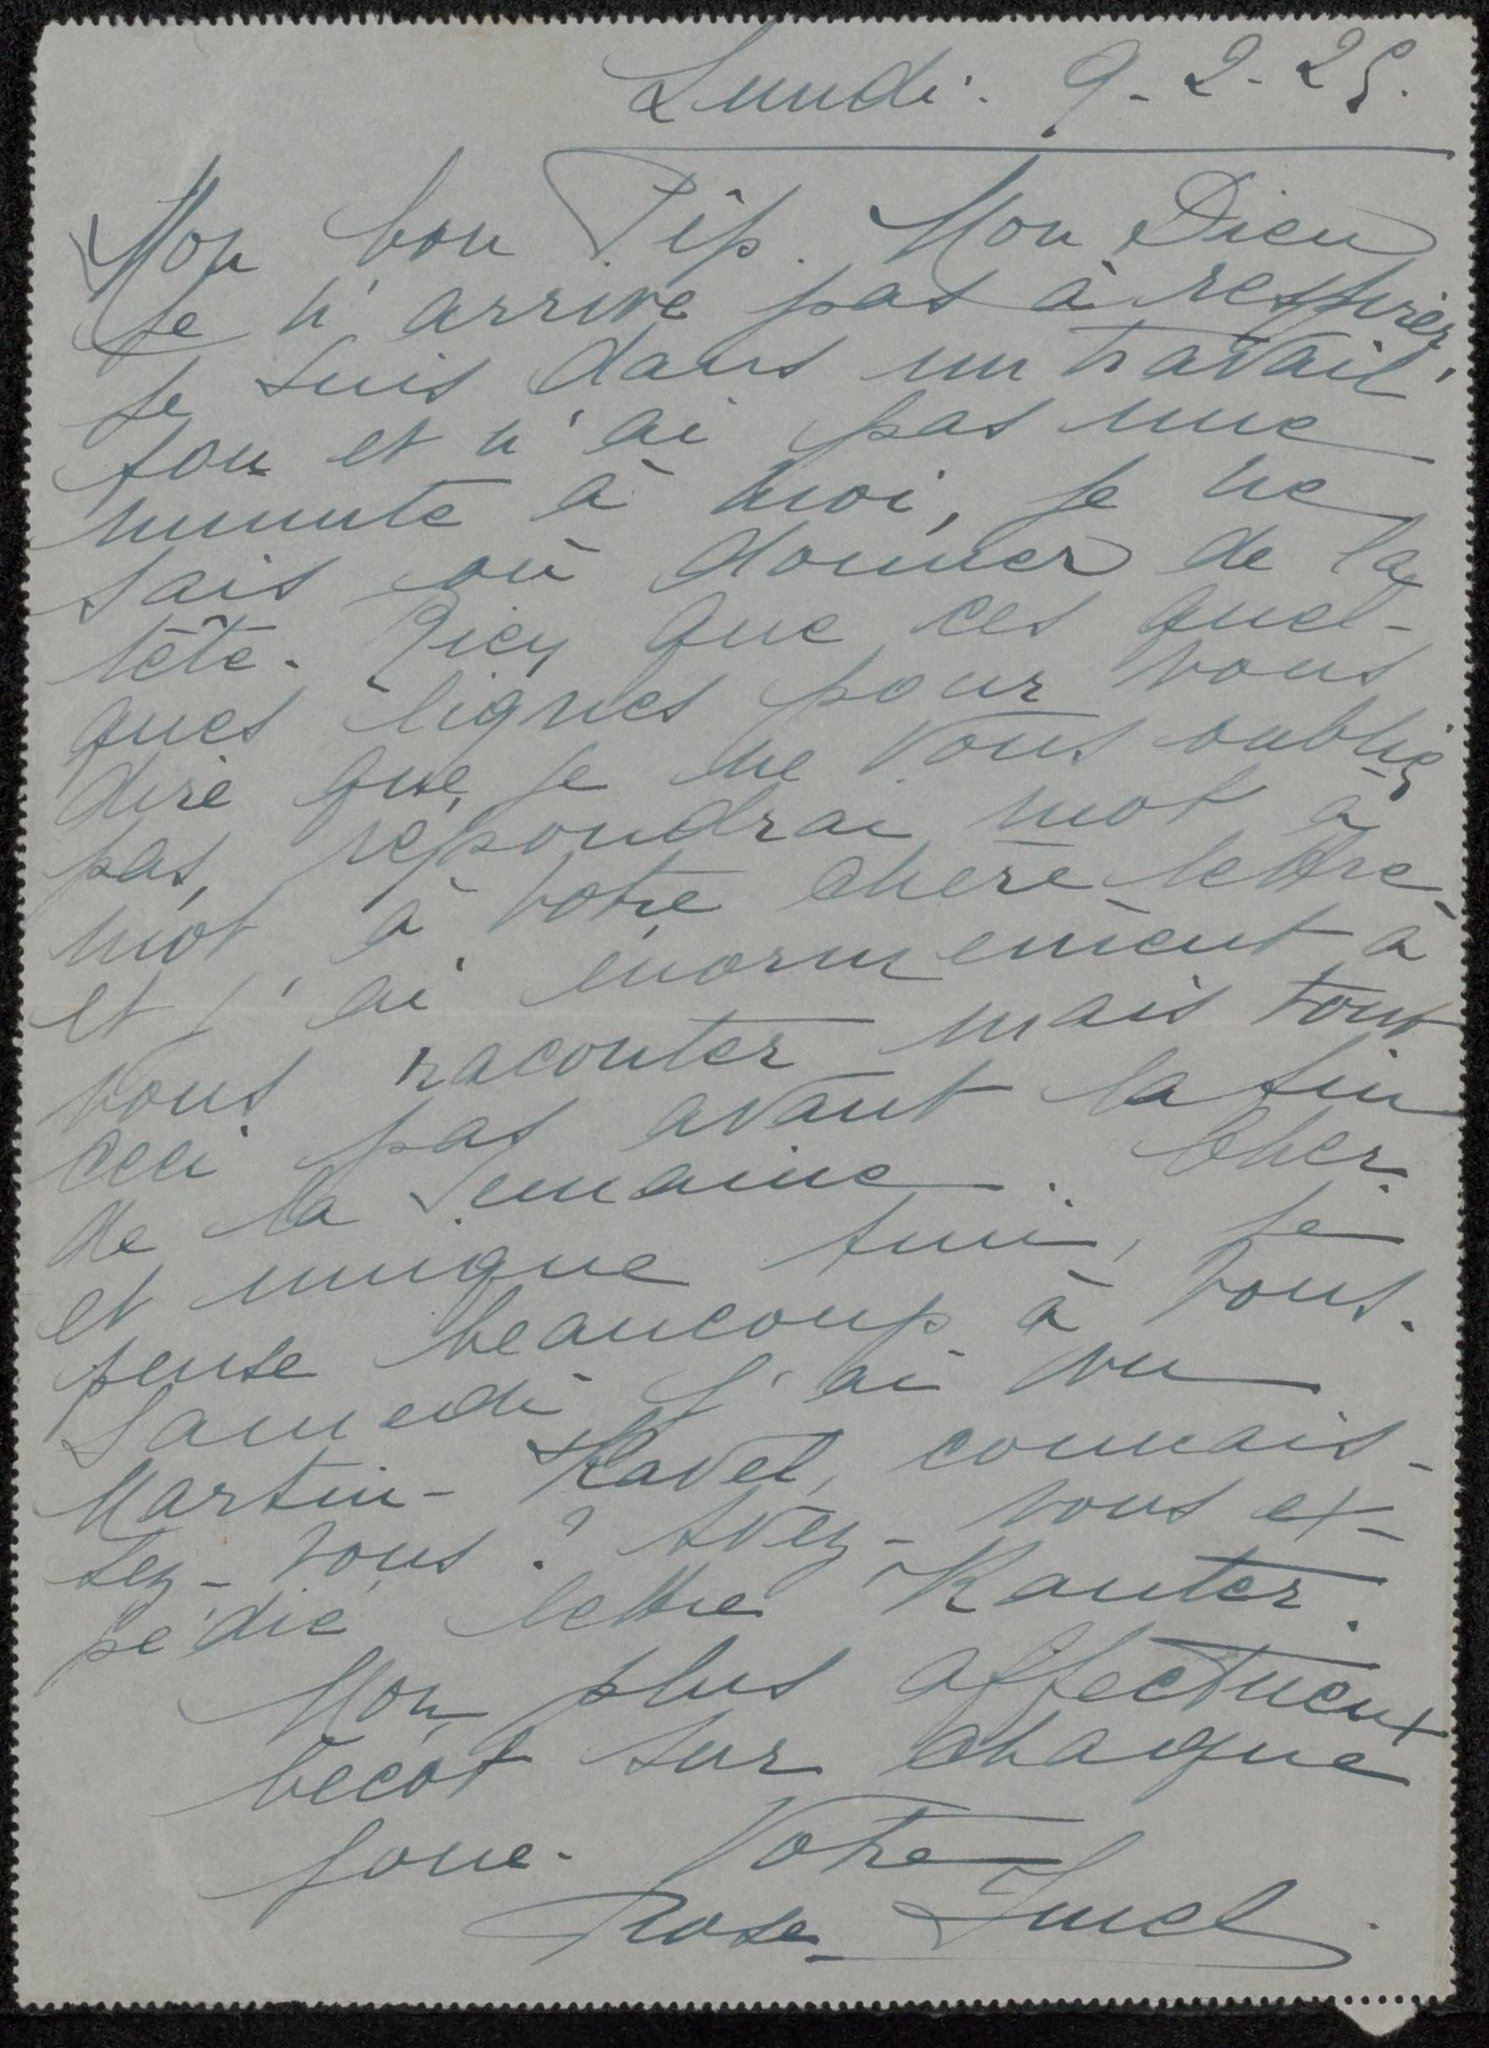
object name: letter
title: Brief aan Philip Zilcken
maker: rose imel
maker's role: draughtsman, painter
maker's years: 1901-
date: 1925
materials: ink, paper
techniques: pen, writing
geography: paris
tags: the hague, painter, draughtsman, philip zilcken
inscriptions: collector's mark: ‘RPK’